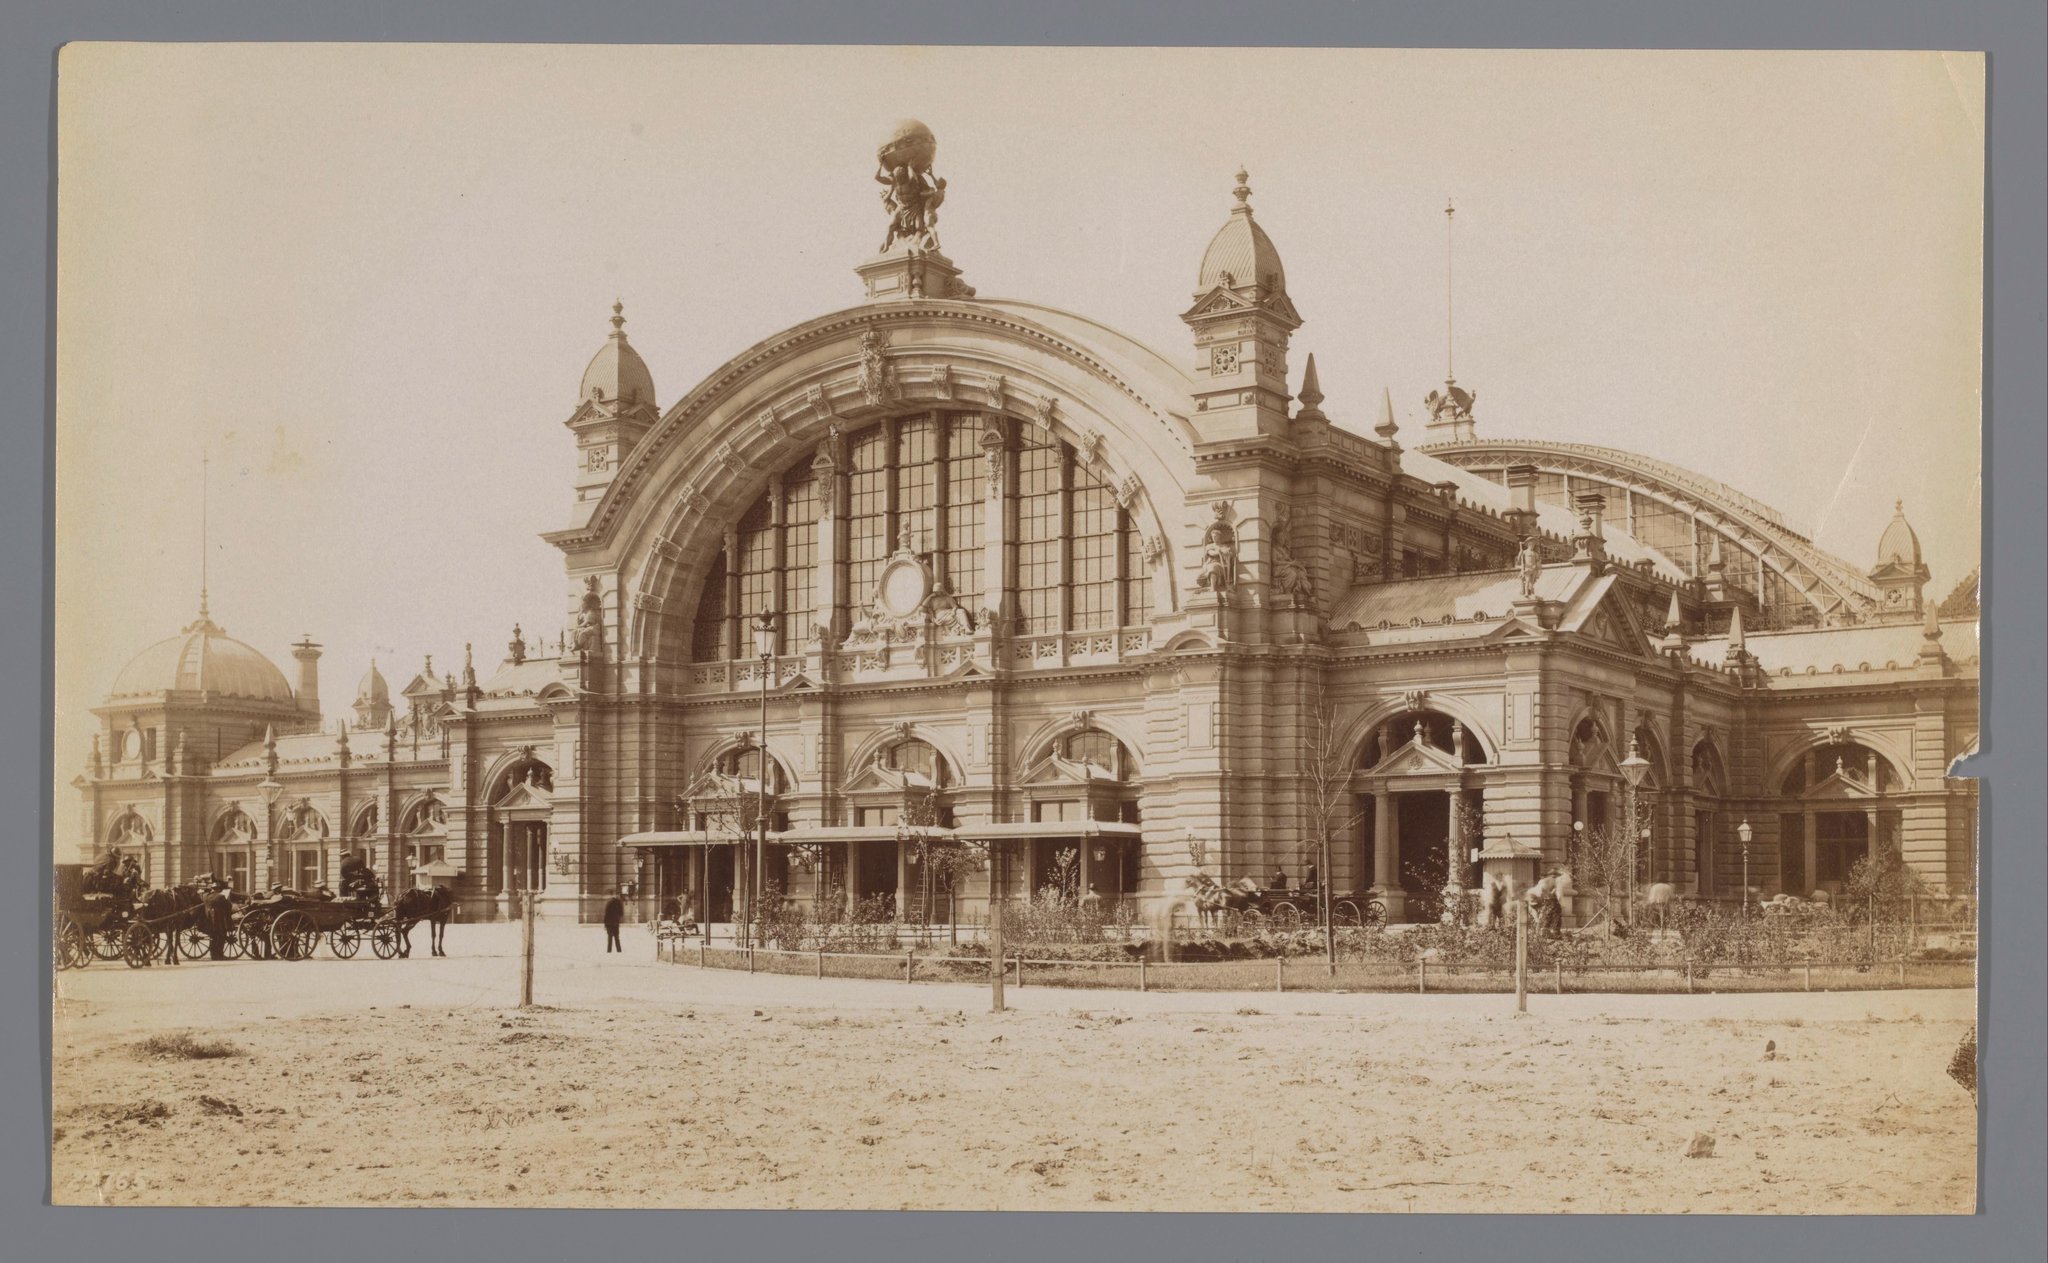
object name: photograph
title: Gezicht op het stationsgebouw van Frankfurt am Main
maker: Anonymous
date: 1888-1900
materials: paper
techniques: albumen print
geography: frankfurt am main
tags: station; shelter (railway, tramway)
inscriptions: number: ‘25765’, inscription: ‘Frankfort/ 25765. Der Neue Bahnhof.’